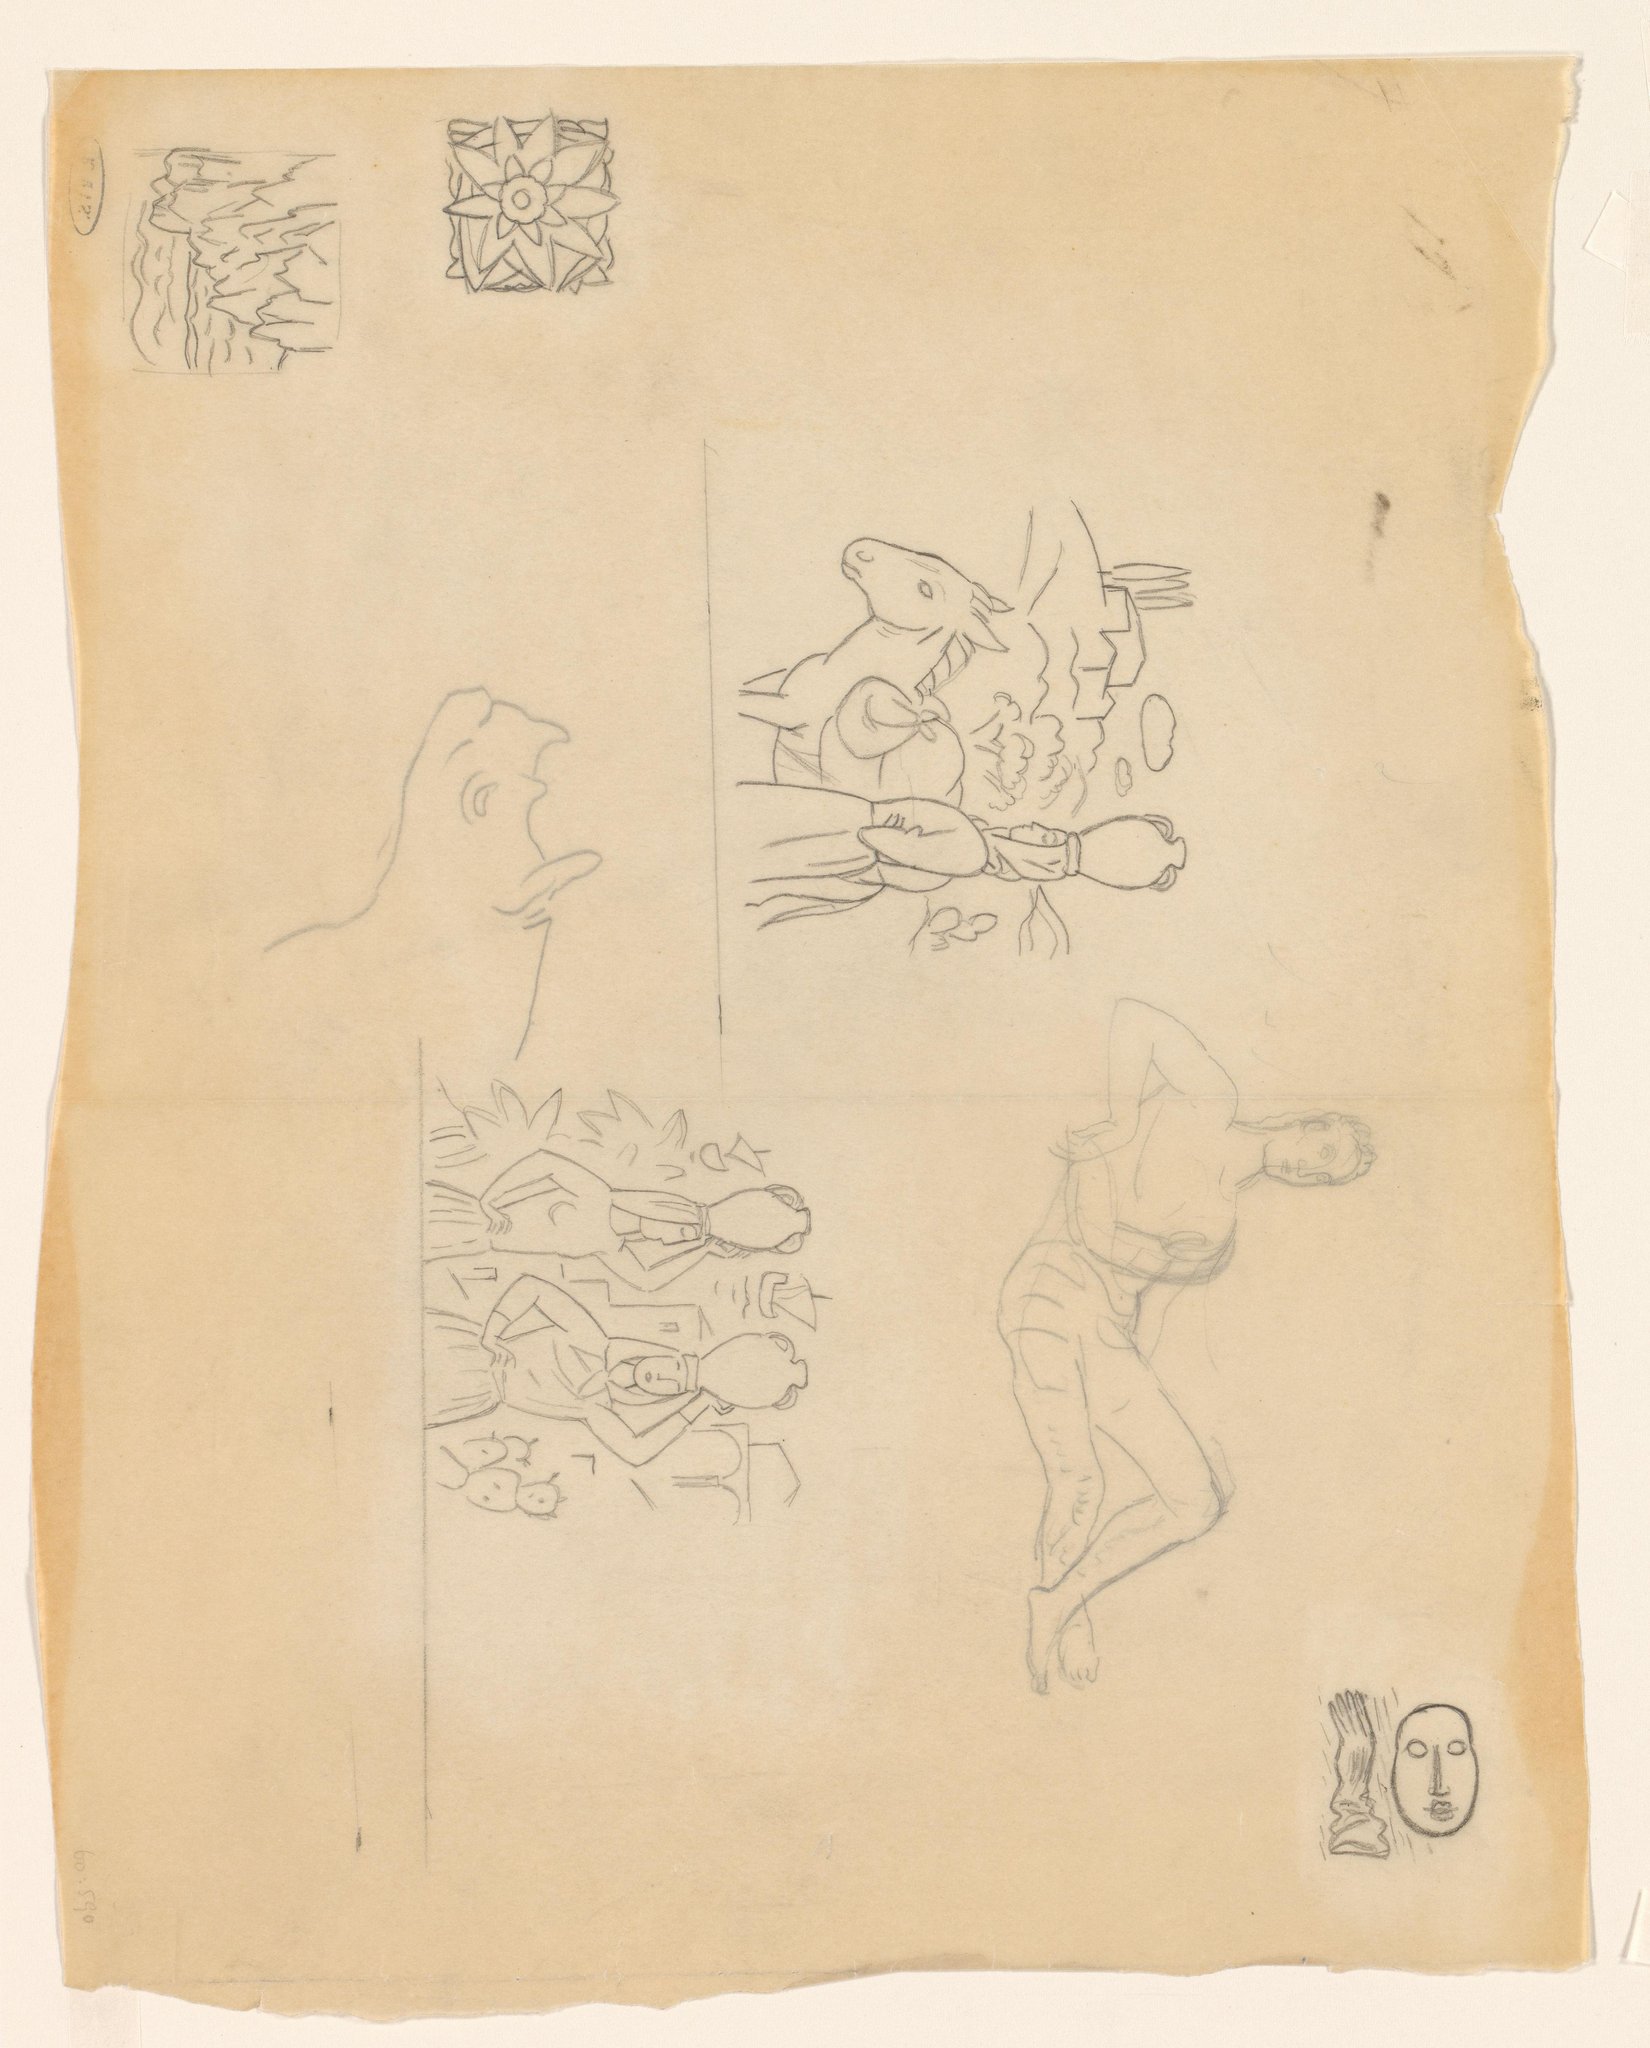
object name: drawing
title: Studieblad met vrouwen die waterkruiken op het hoofd dragen en enkele andere schetsen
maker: leo gestel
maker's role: draughtsman, print maker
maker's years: 1881-1941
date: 1891-1941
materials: chalk, pencil, paper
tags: ass, donkey, container of ceramics: jar, jug, pot, vase, male sex; man